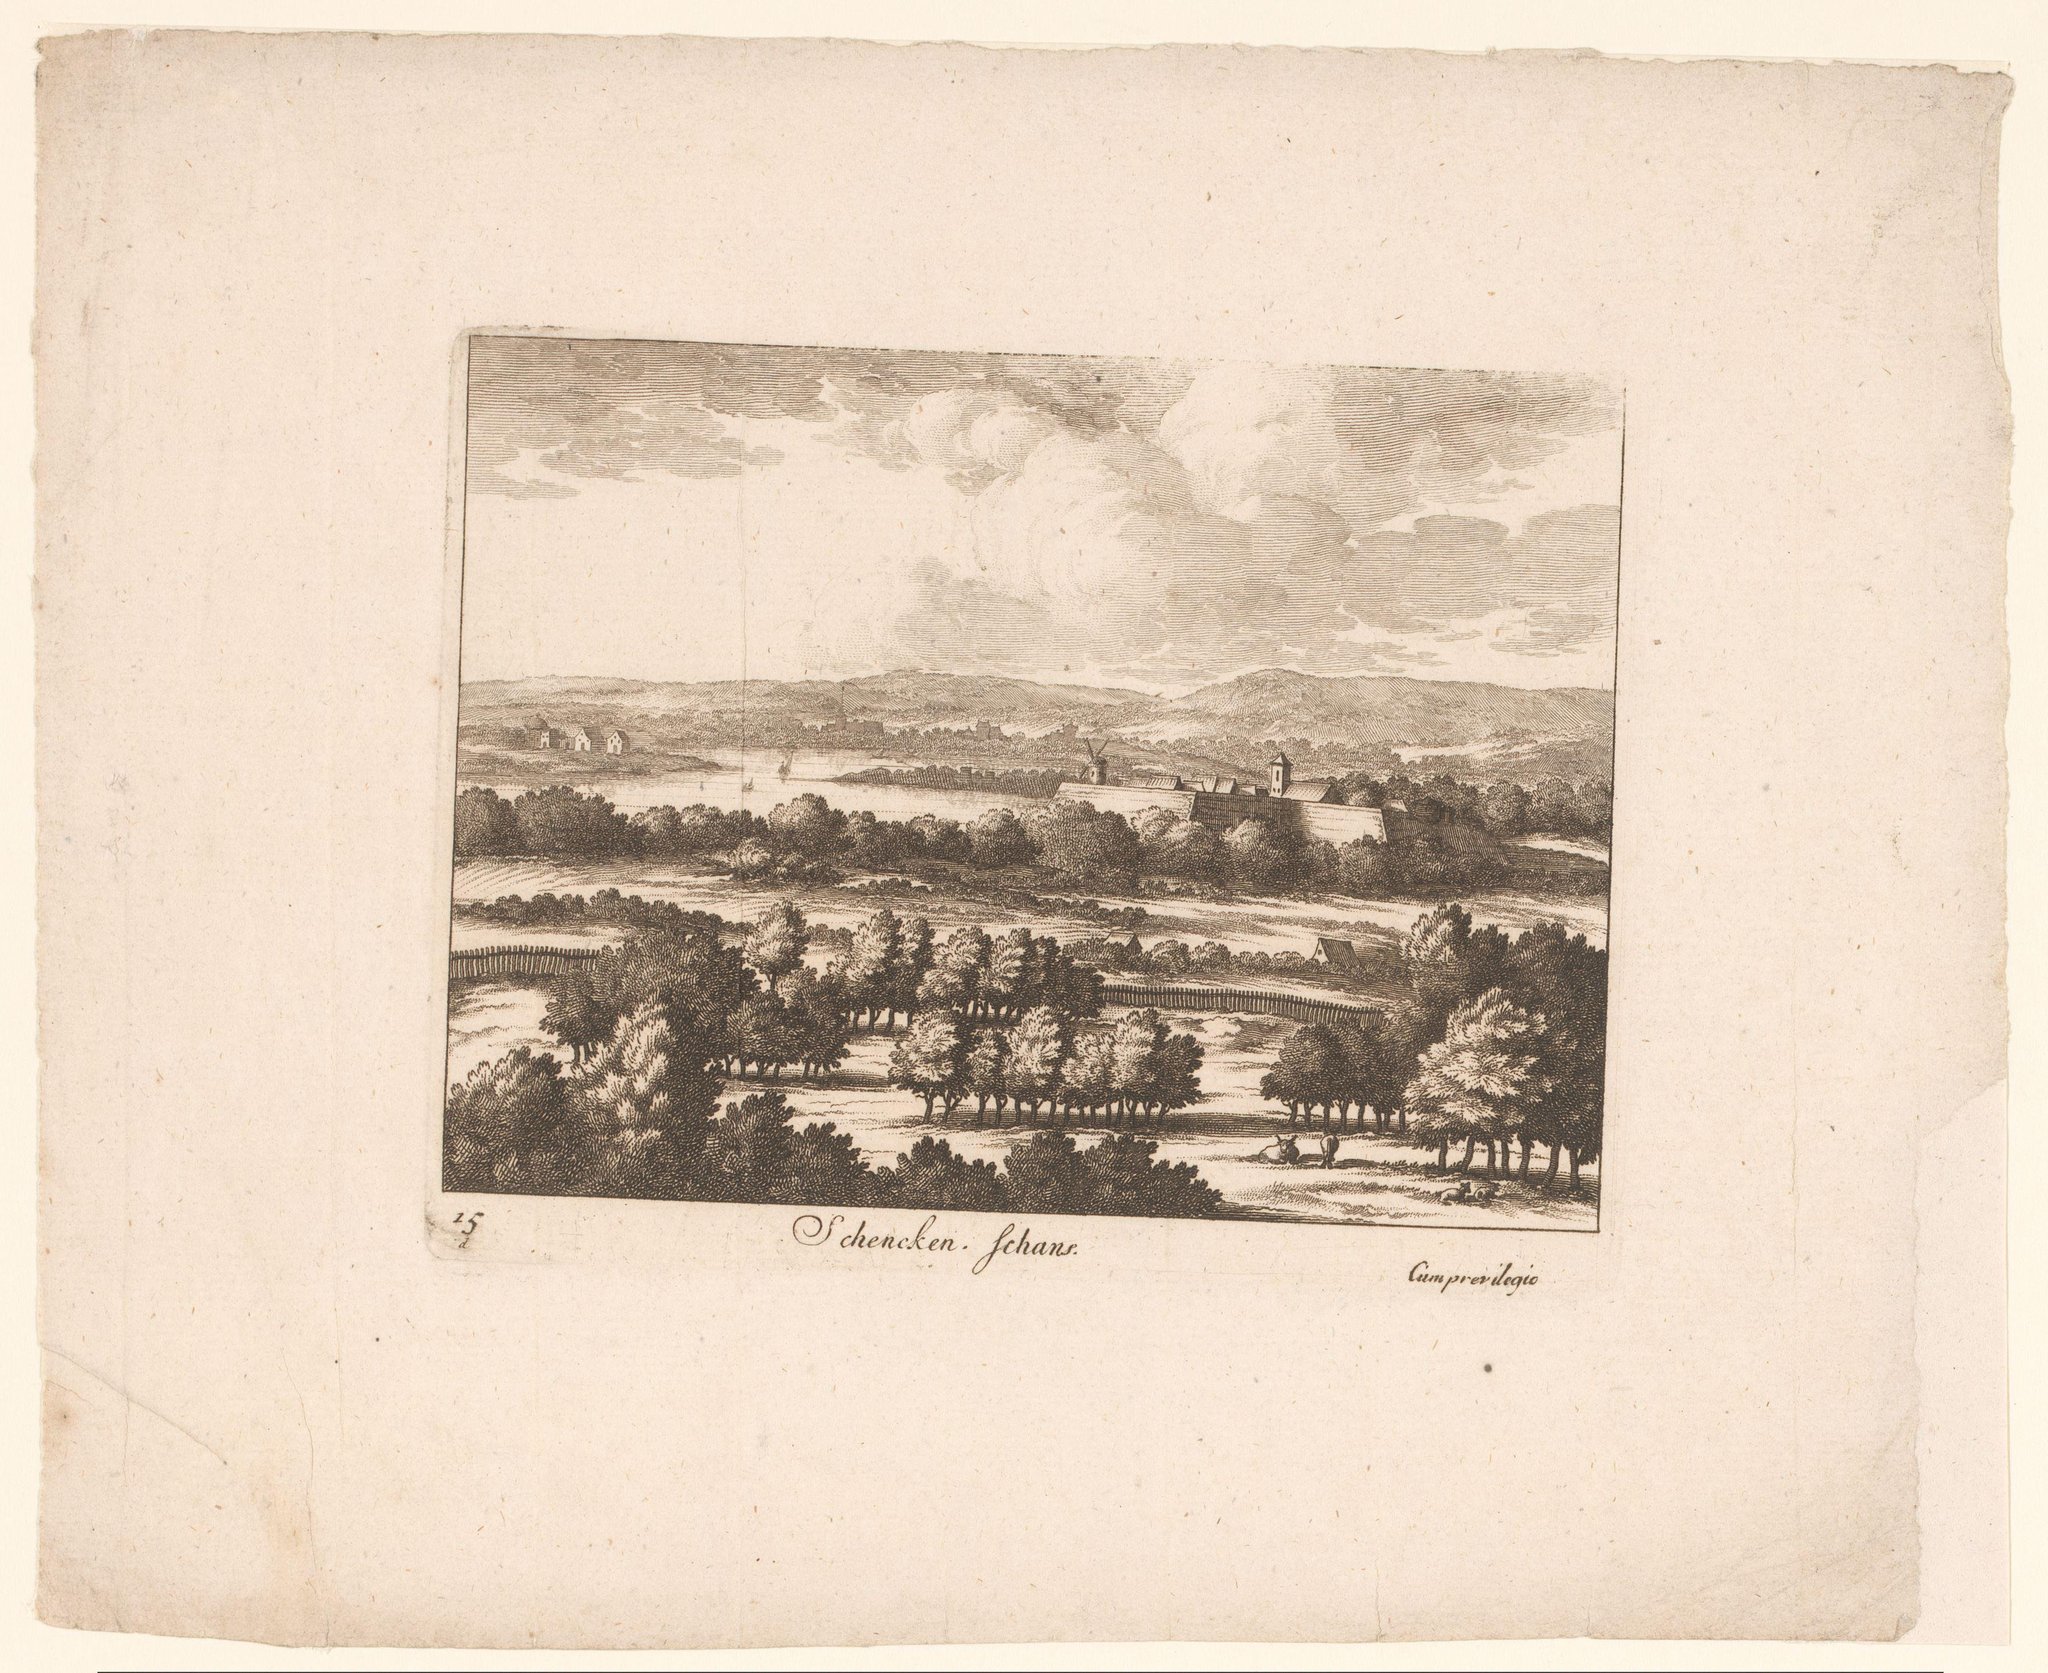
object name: print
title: Schencken-Schans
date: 1695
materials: paper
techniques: engraving, etching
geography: amsterdam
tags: fortress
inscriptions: collector's mark: Lugt 2228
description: Prent ook gebruikt in: Veues et perspectives de la ville de Cleves, et de sa cour. Amsterdam: Gerard Valck, 1695.